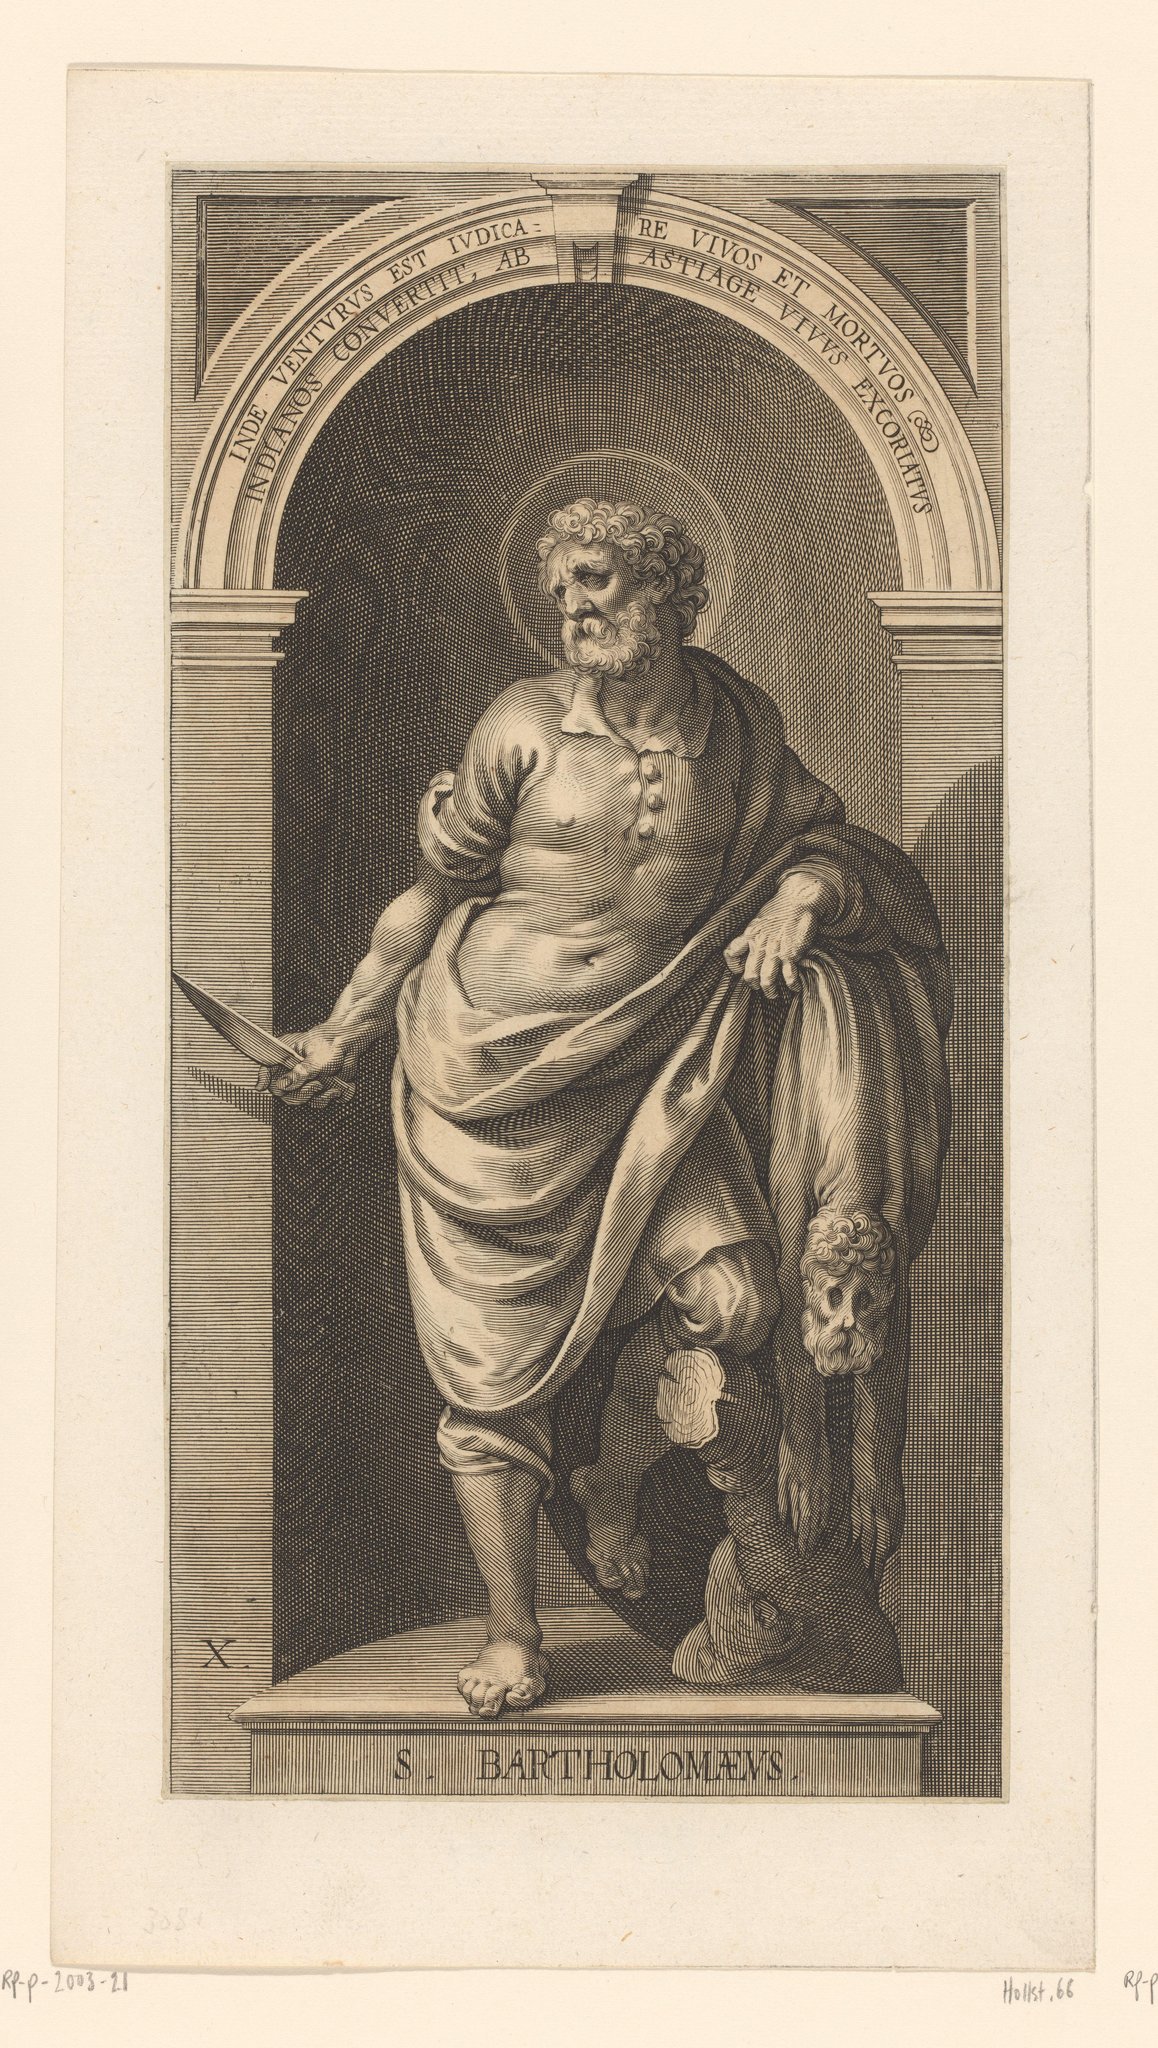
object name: print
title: Sanctuarium Christianorum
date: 1623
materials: paper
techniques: engraving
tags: the apostle bartholomew; possible attributes: book, devil or dragon at feet, knife, scroll, flayed skin, staff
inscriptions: collector's mark: Lugt 2760, collector's mark: Lugt 567, collector's mark: Lugt 2228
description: Tekst uit een Bijbelpassage in het Latijn in de bogen van de nis.